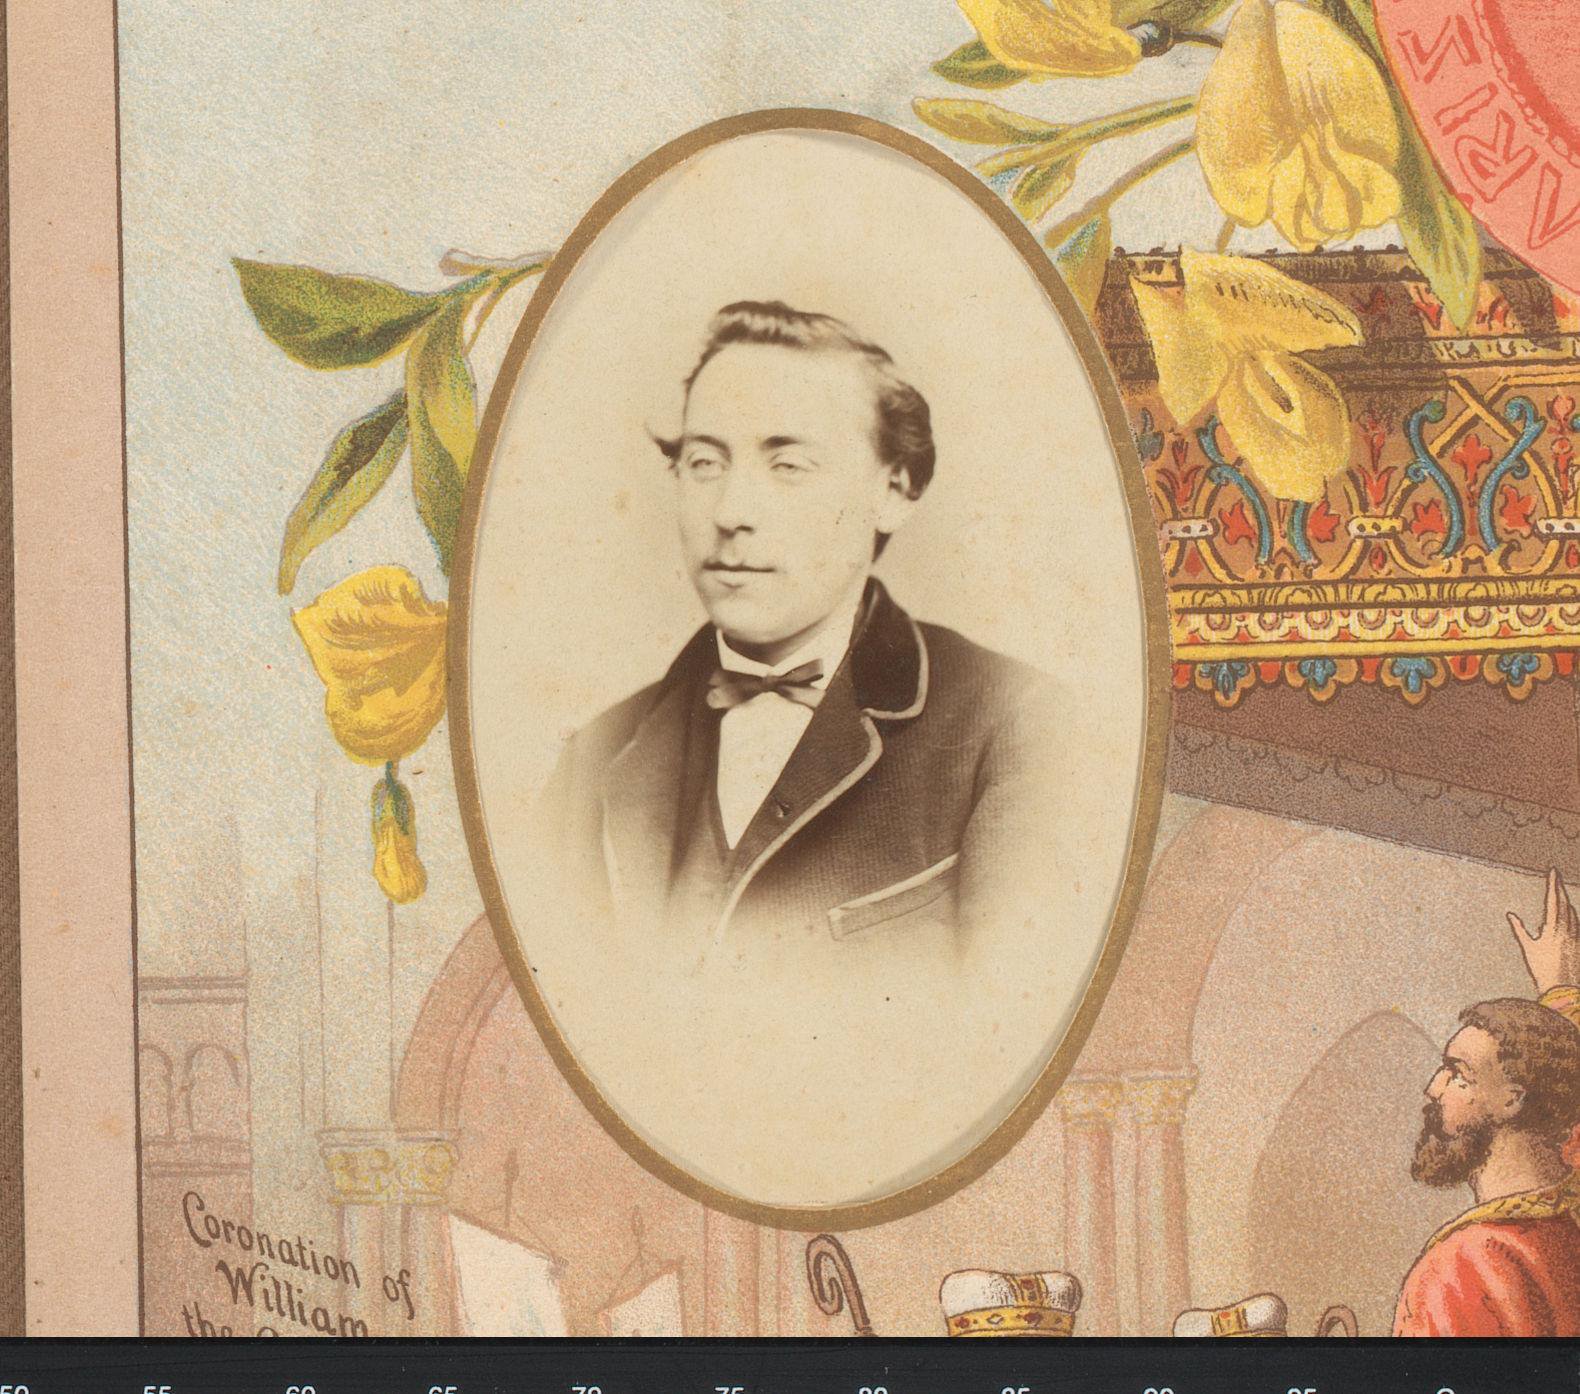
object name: album leaf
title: Portret van een man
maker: john hatherill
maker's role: fotograaf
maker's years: 1839-1908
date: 1880-1908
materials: cardboard, photographic support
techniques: albumen print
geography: london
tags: historical persons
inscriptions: inscription: ‘J. Hatherill/ Photographer/ 3, Jamaica Terrace, Jamaica Level/ BERMONDSEY/ NO CONNECTION WITH ANY OTHER ESTABLISHMENT./ Copies may be had by sending/ This Number No. 997’